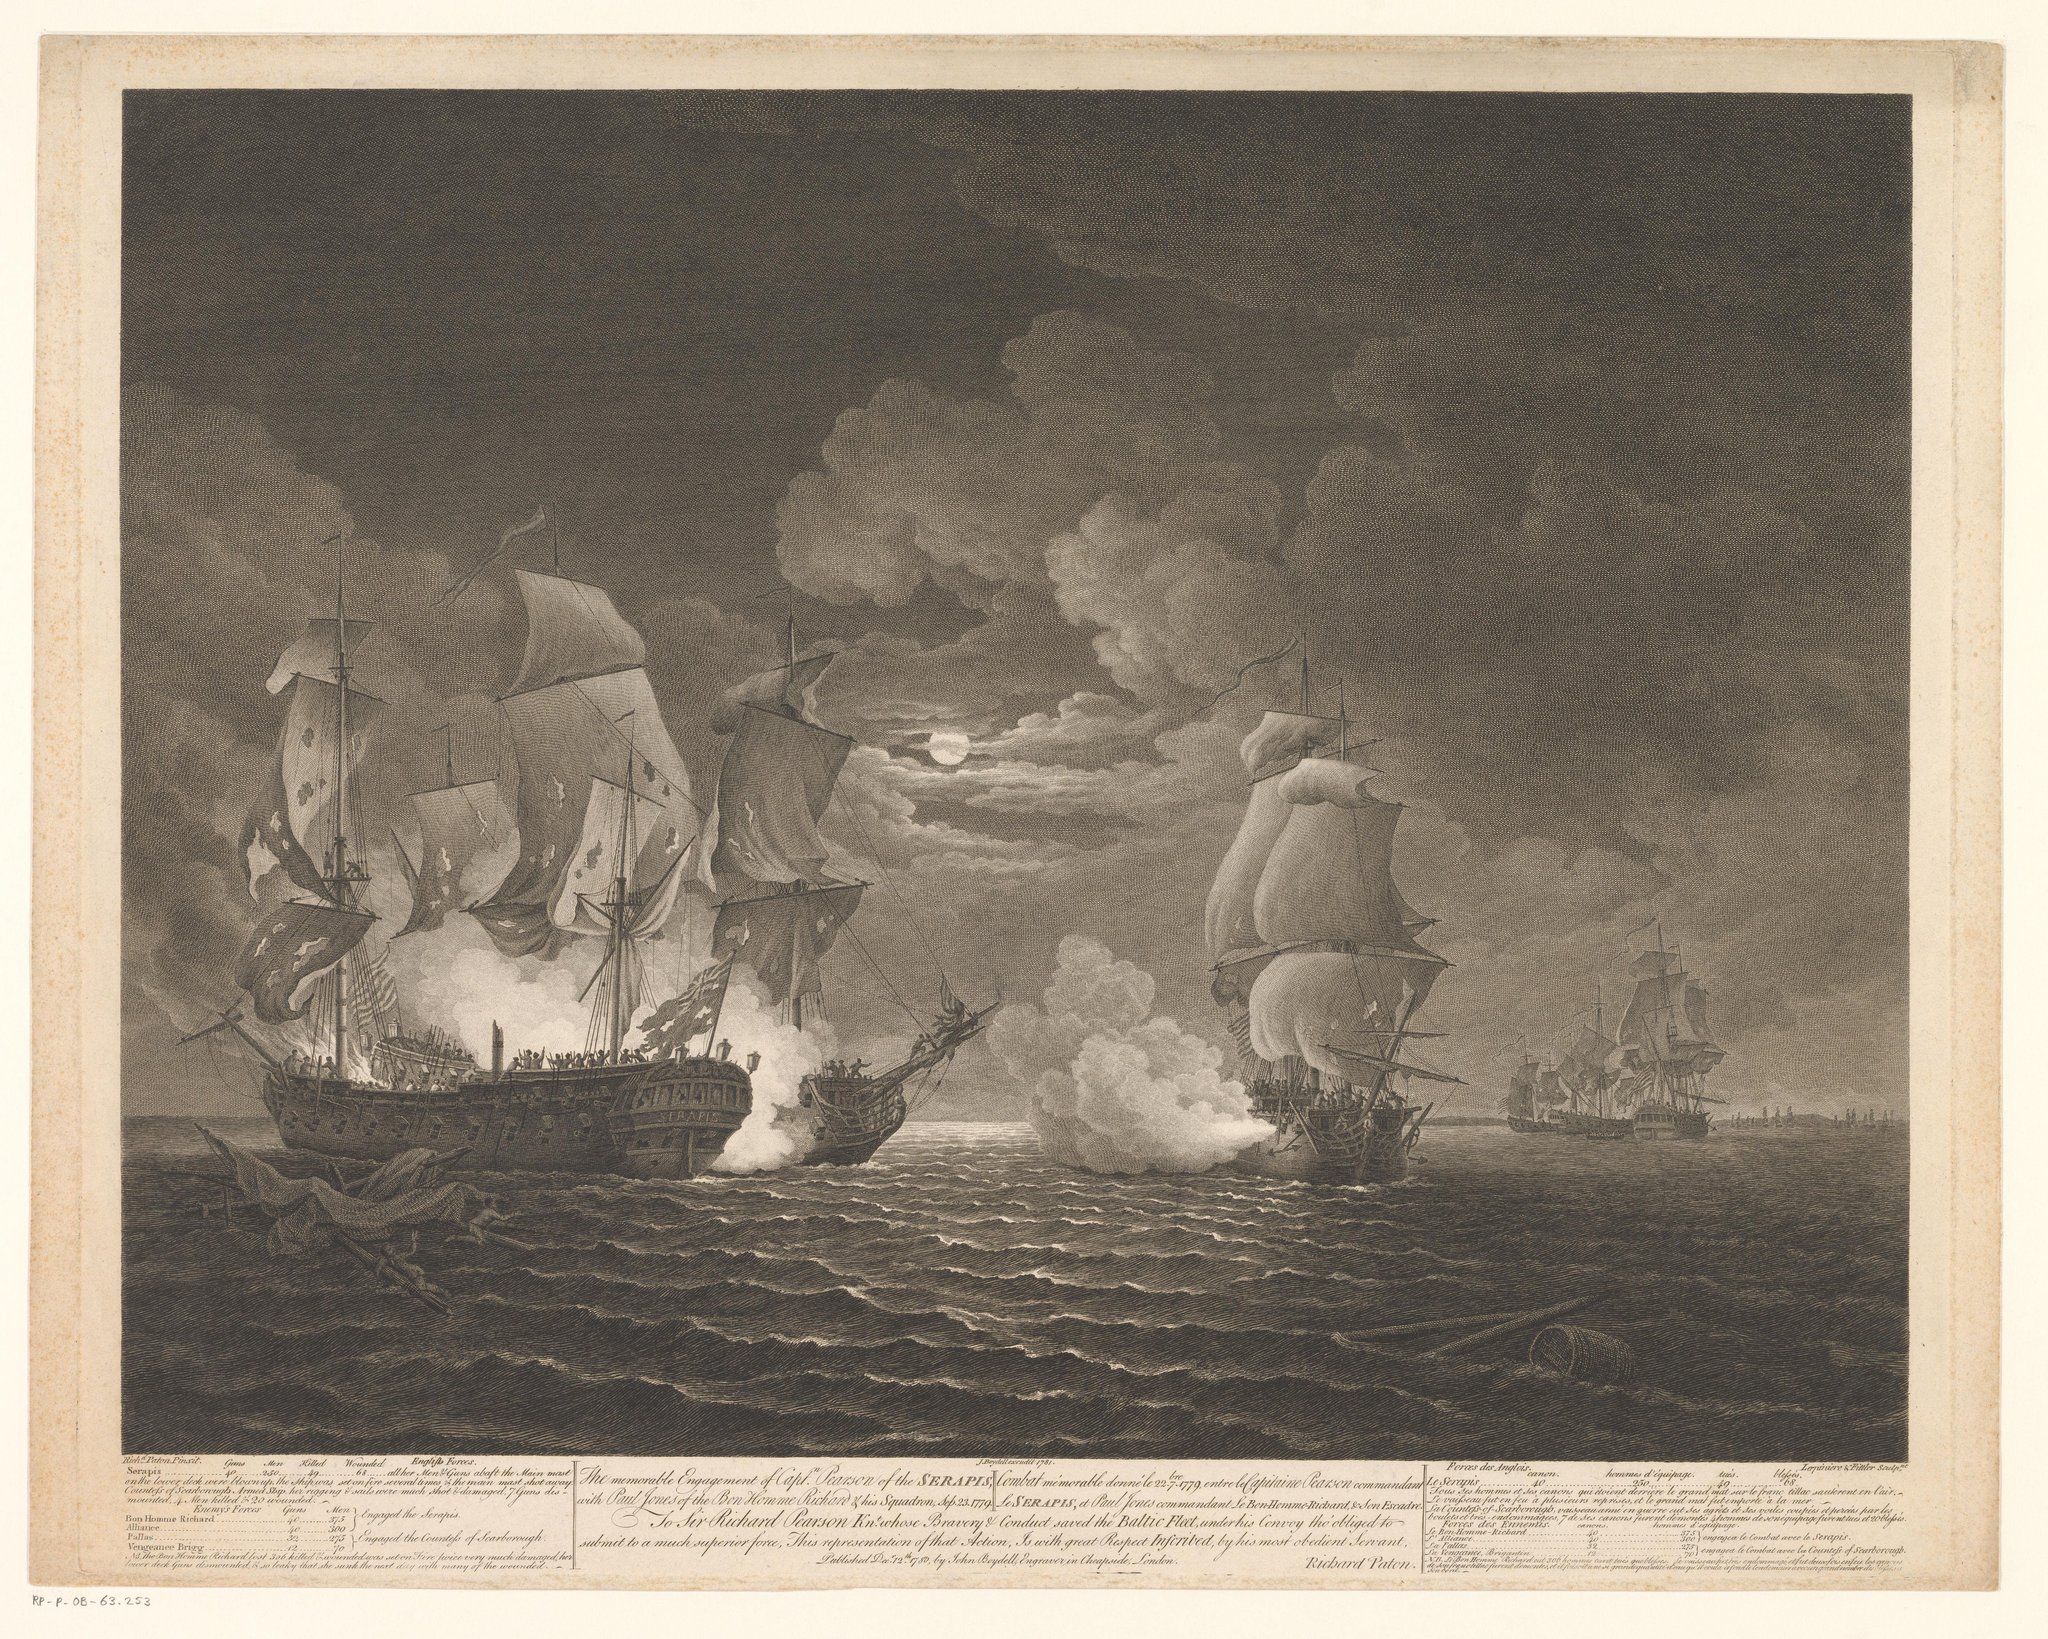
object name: print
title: The memorable engagement of Captain Pearson of the Serapis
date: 1781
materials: paper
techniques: engraving, etching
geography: england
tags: richard pearson, capuche, full moon, historical persons, ships (in general) - cc - more than one ship, battle (+ sailing-ships)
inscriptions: collector's mark: Lugt 2228